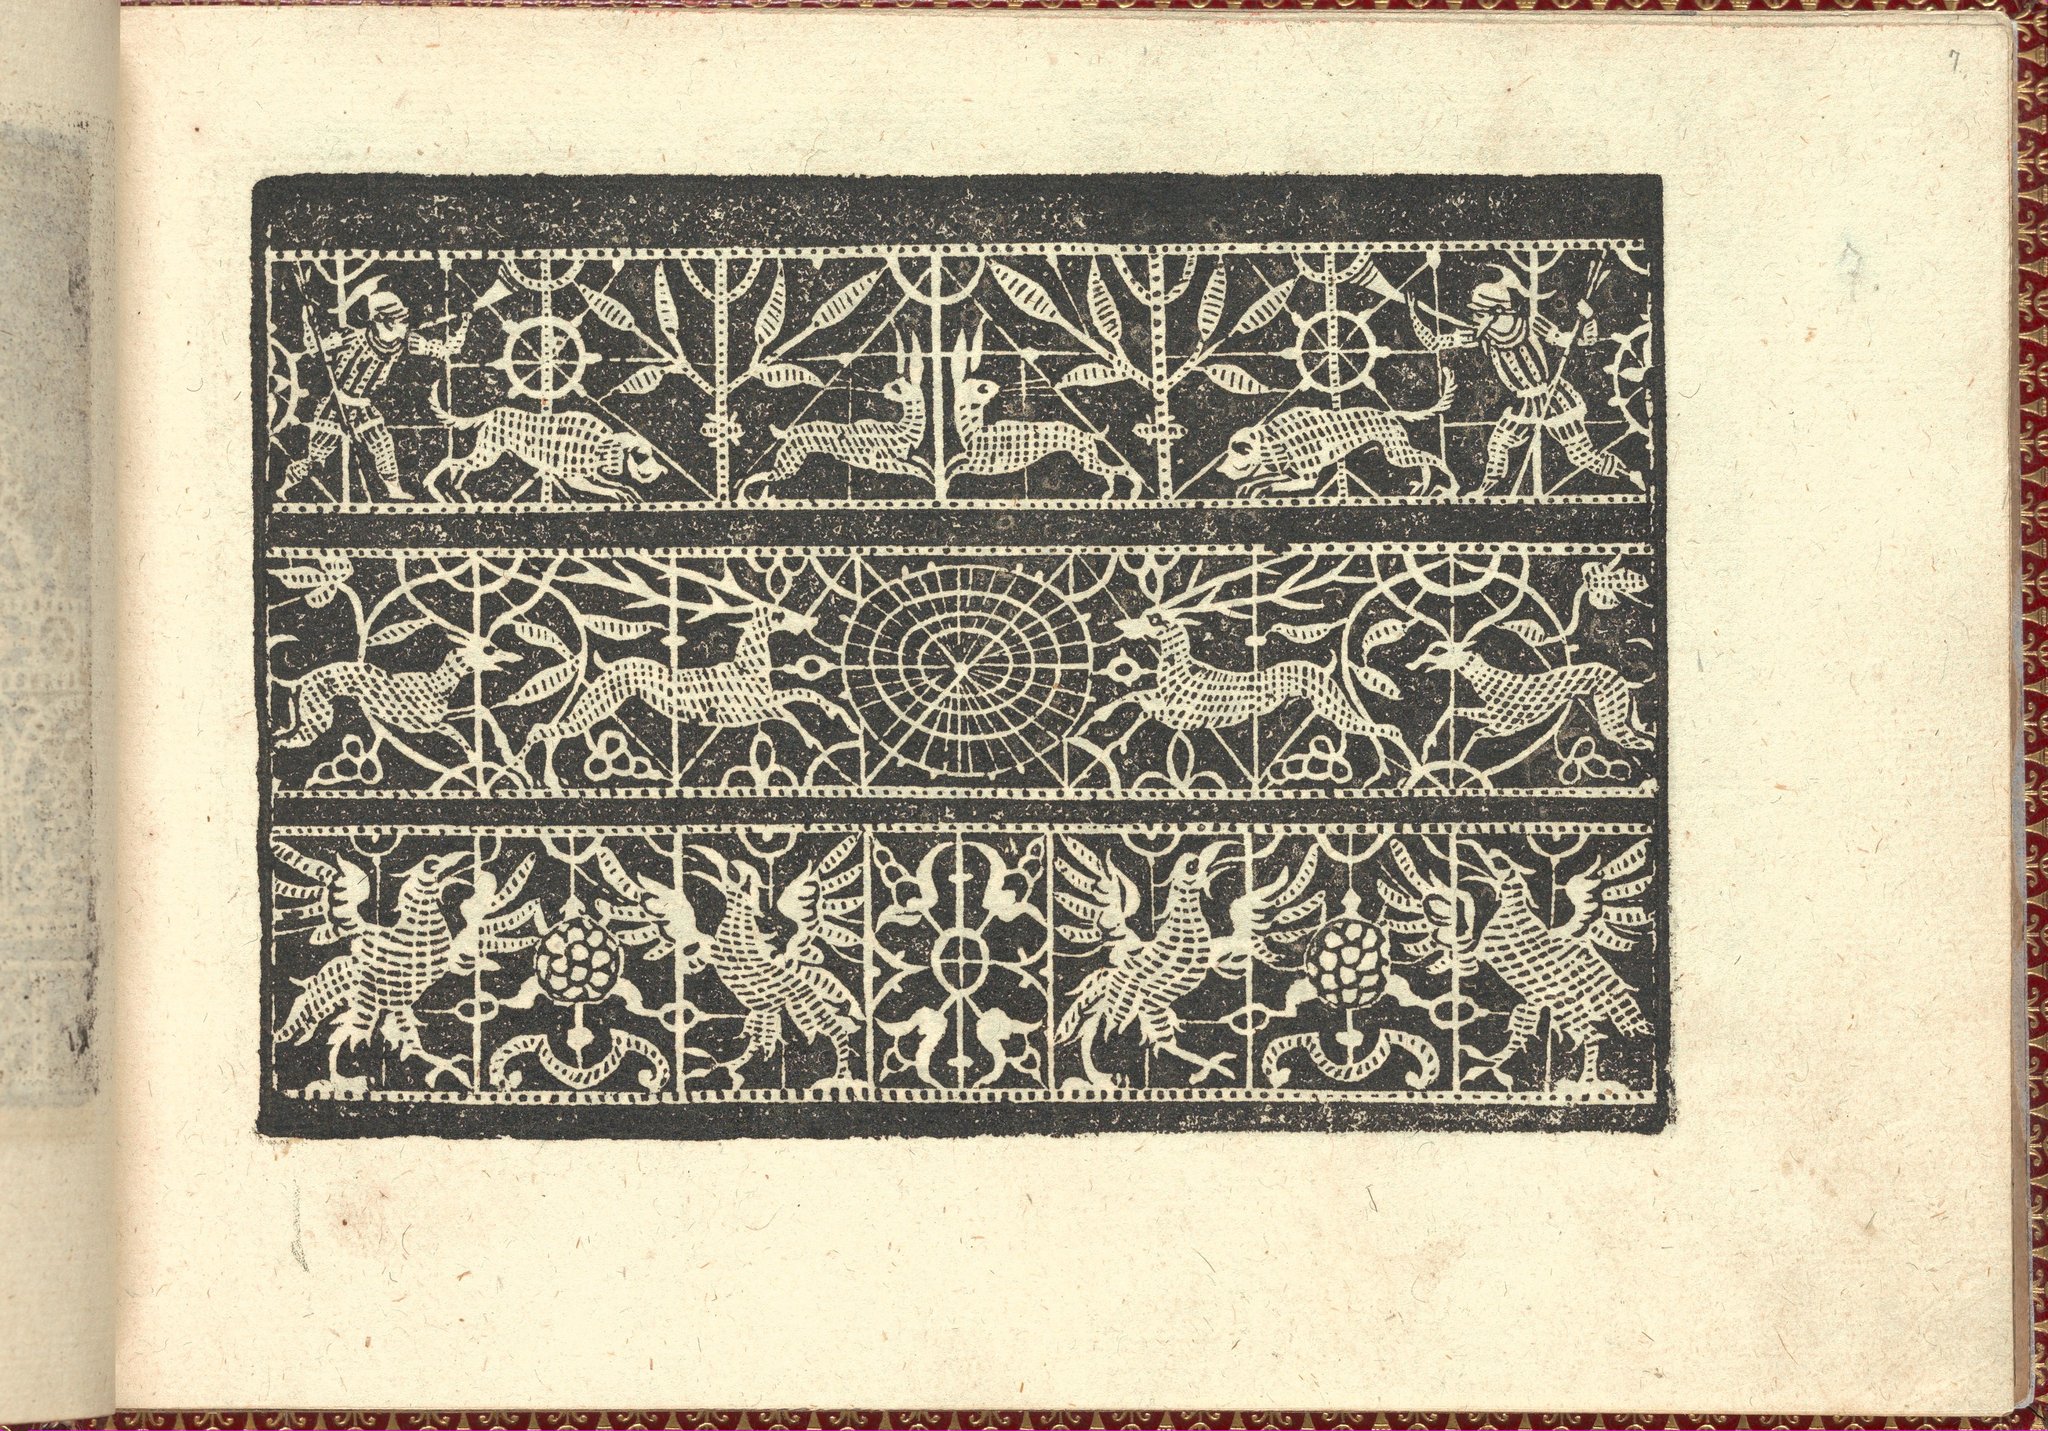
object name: book print ornament architecture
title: Corona delle Nobili et Virtuose Donne: Libro I-IV, page 7 (recto)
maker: cesare vecellio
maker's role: publisher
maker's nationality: italian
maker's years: 1521-1601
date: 1601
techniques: woodcut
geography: italy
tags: birds,men,hunting,deer,dogs,rabbits